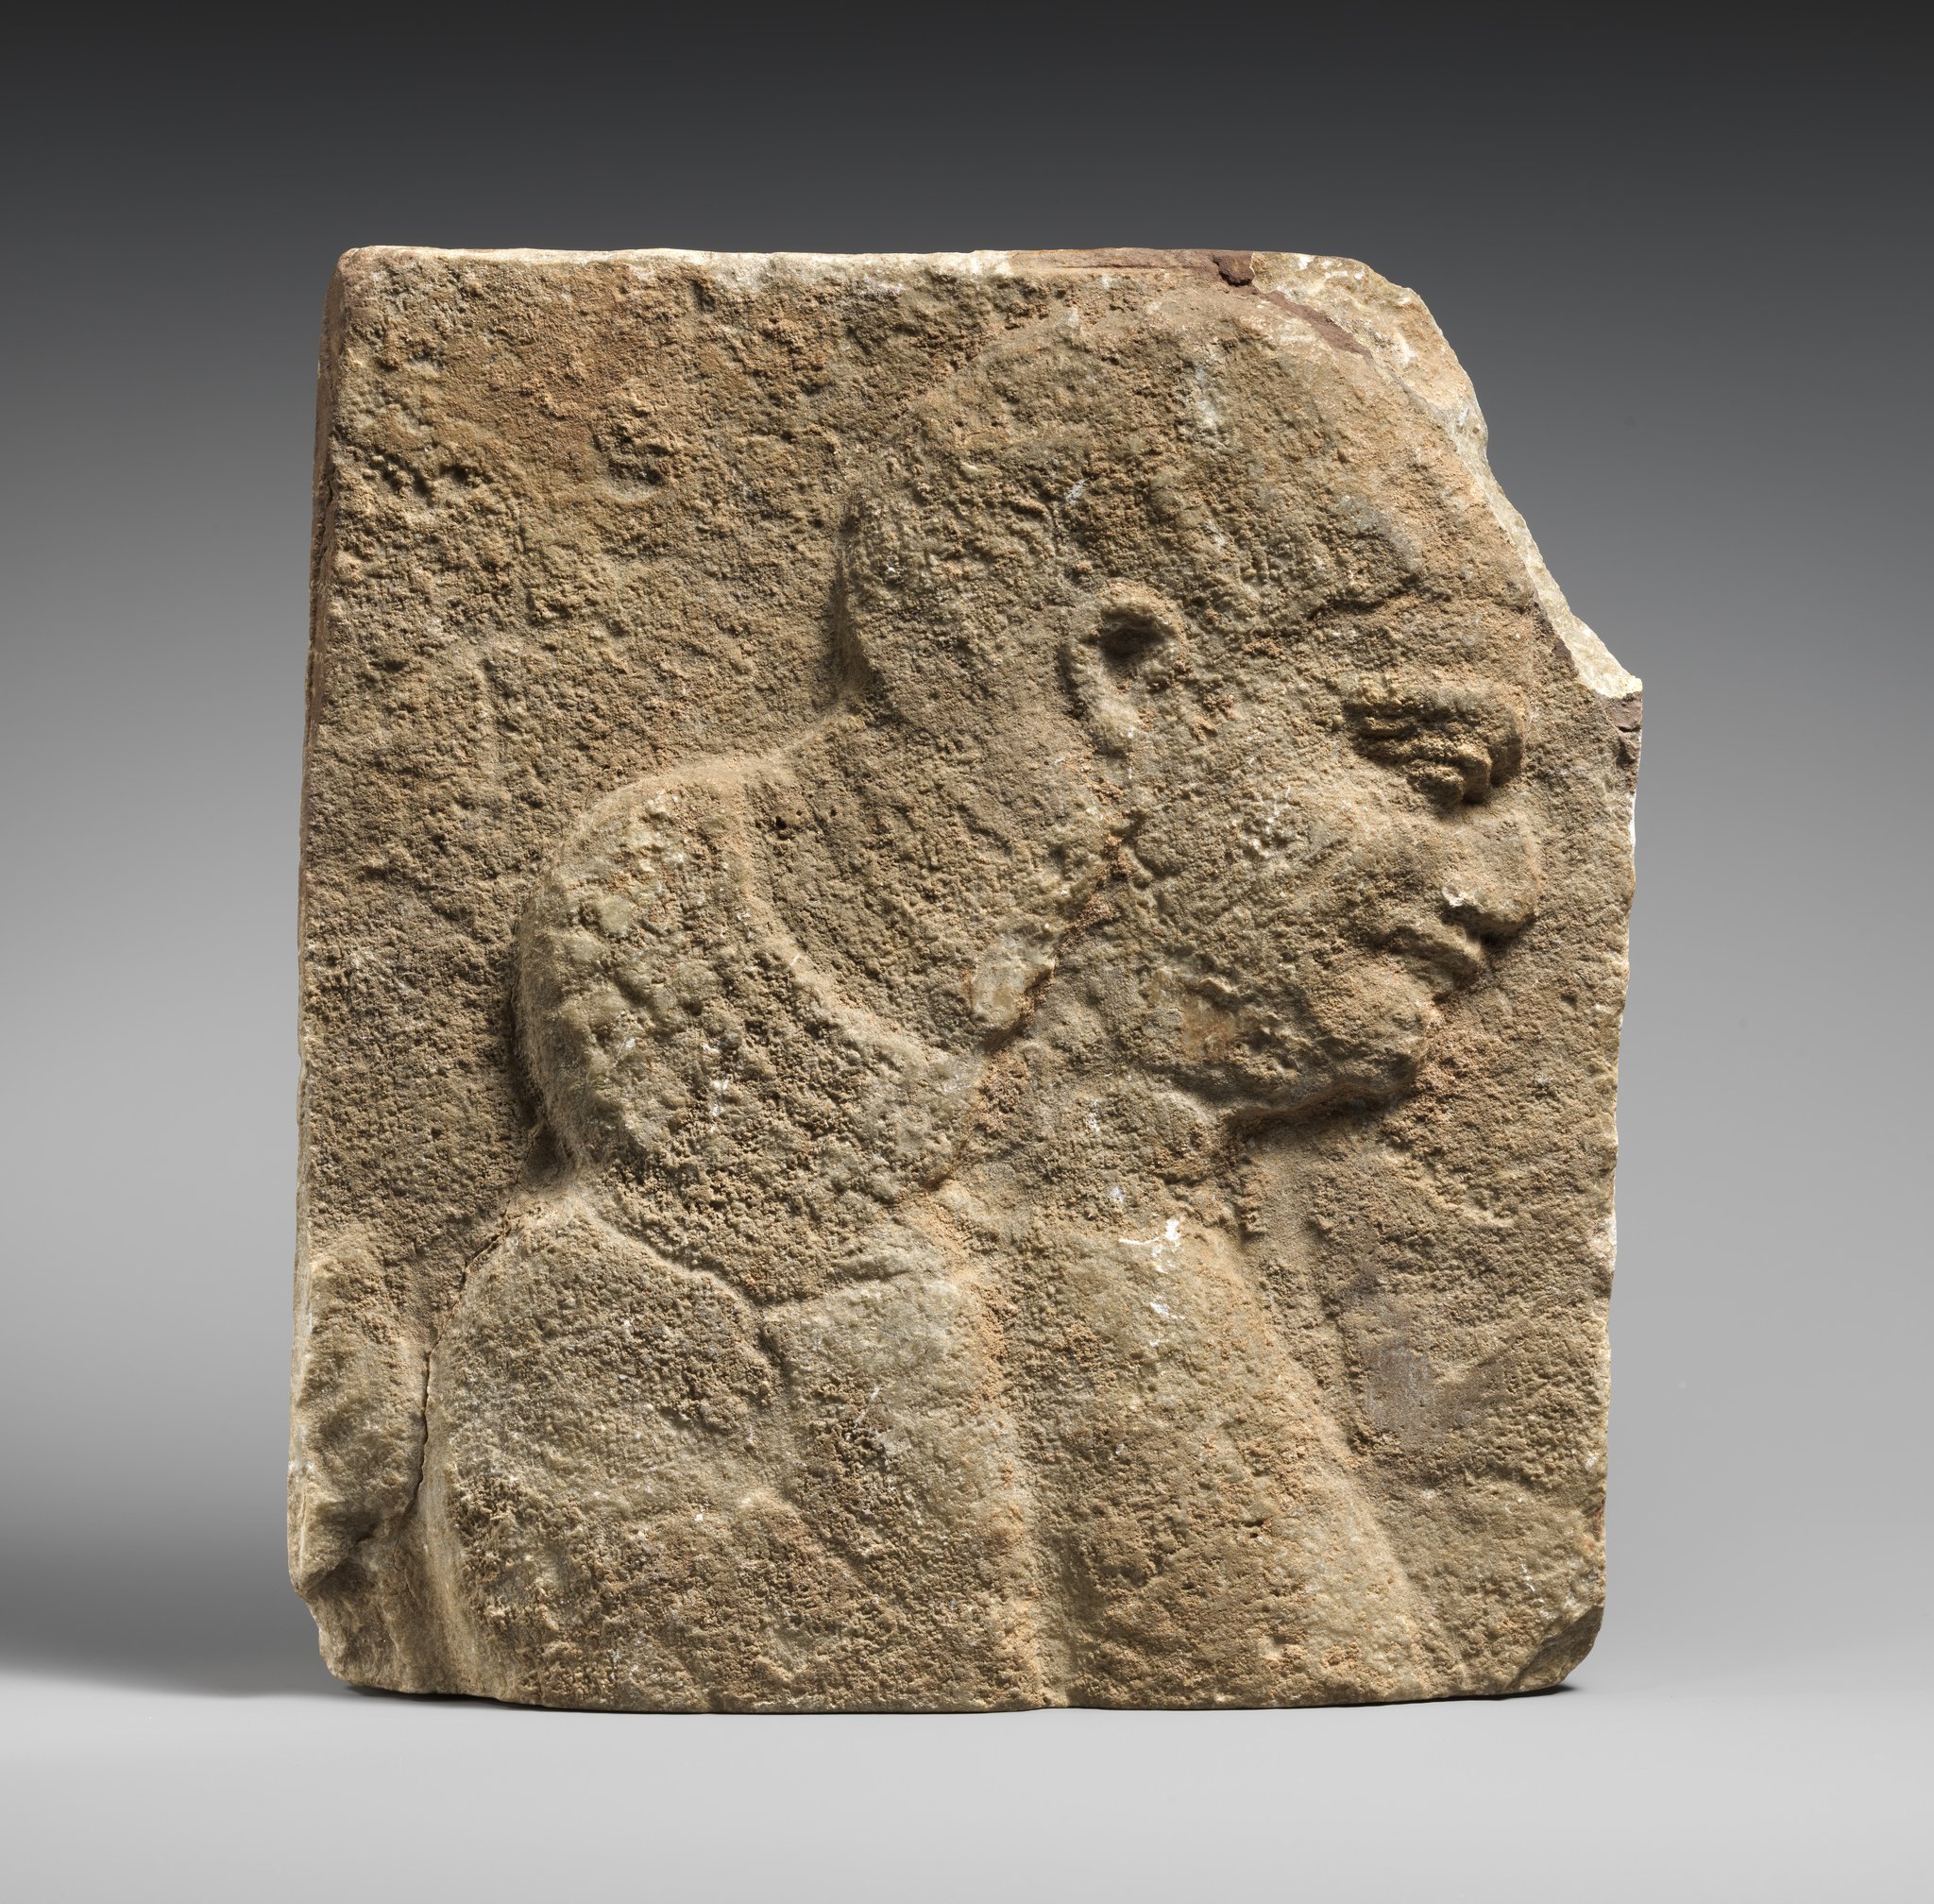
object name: relief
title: Relief: head and shoulders of a beardless man, possibly a eunuch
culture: assyrian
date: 721-705 BCE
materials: alabaster, gypsum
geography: mesopotamia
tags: men